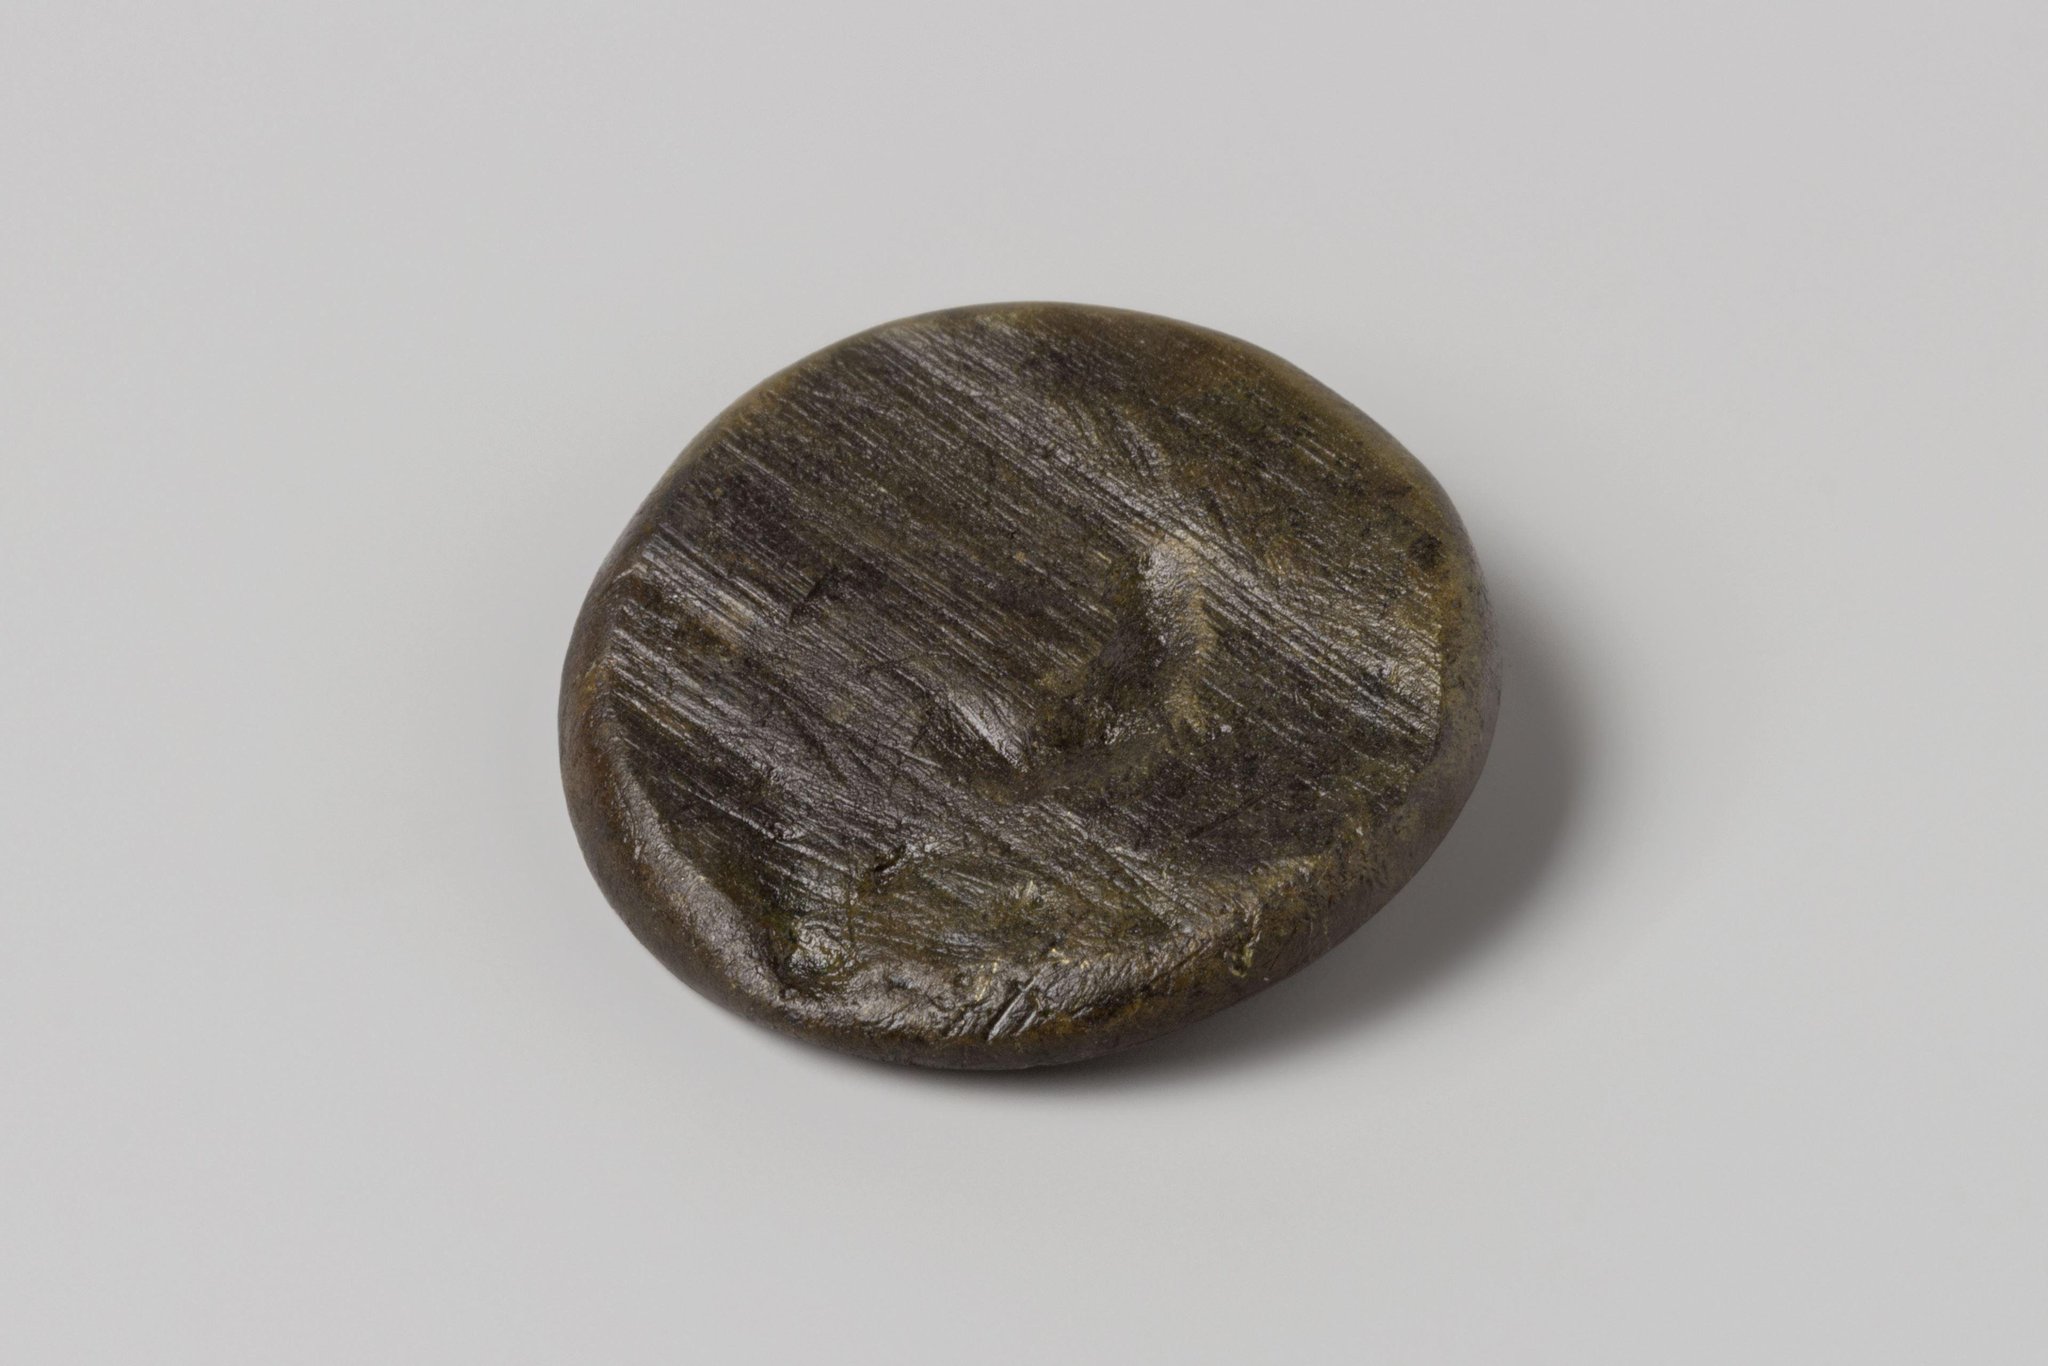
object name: button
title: Knoop uit het wrak van de Oost-Indiëvaarder Hollandia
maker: Anonymous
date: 1700-1743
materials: copper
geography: netherlands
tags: verenigde oostindische compagnie, hollandia (schip), annet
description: Knoop. (1) flat top and base, plain, bevelled rim (2.6d, 0.3t), loop-shank damaged